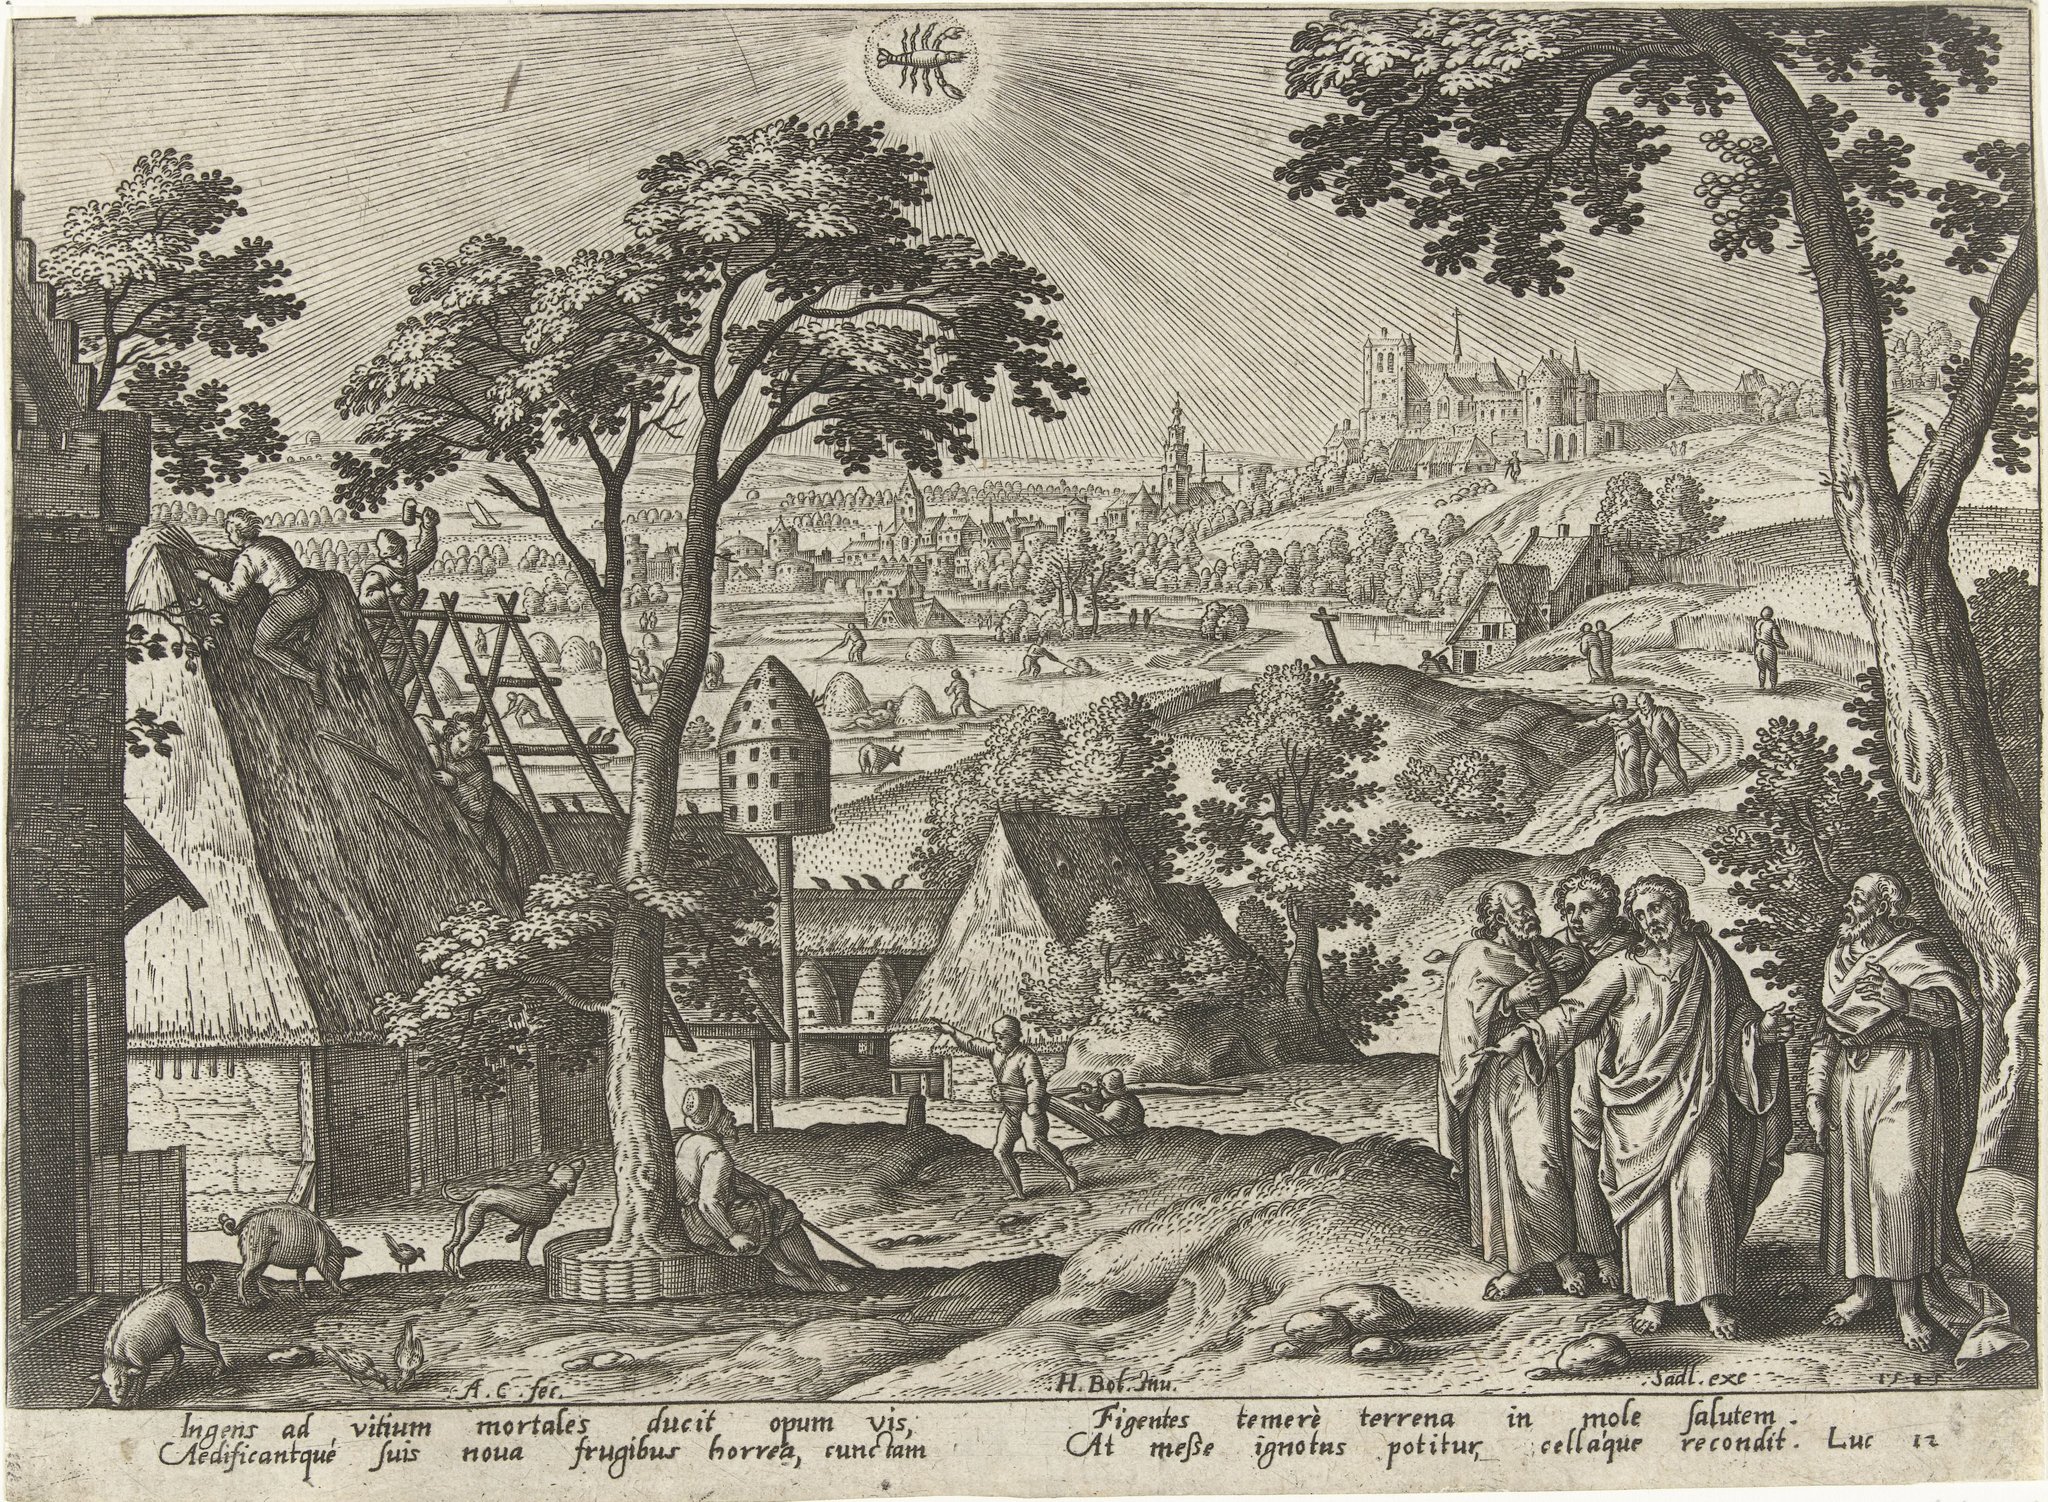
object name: print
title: Juni: de parabel van de hebzuchtige boer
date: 1585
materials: paper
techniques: engraving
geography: antwerp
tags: the rich fool, whose death comes when he has saved all his money to build new barns (luke 12:16-21), landscape symbolizing june (+ with cancer (june))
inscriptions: collector's mark: Lugt 2760, collector's mark: Lugt 2228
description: Een zomerlandschap. In de lucht het astrologisch teken van juni: Kreeft. In de rechterhoek vertelt Christus de parabel van de hebzuchtige boer aan zijn leerlingen. Centraal werken arbeiders aan de bouw van een grotere schuur voor de hebzuchtige boer, die tegen een boom aanzit (Luc. 12). De prent heeft een Latijns onderschrift en is deel van een serie over het leven van Christus uitgebeeld in de twaalf maanden van het jaar.